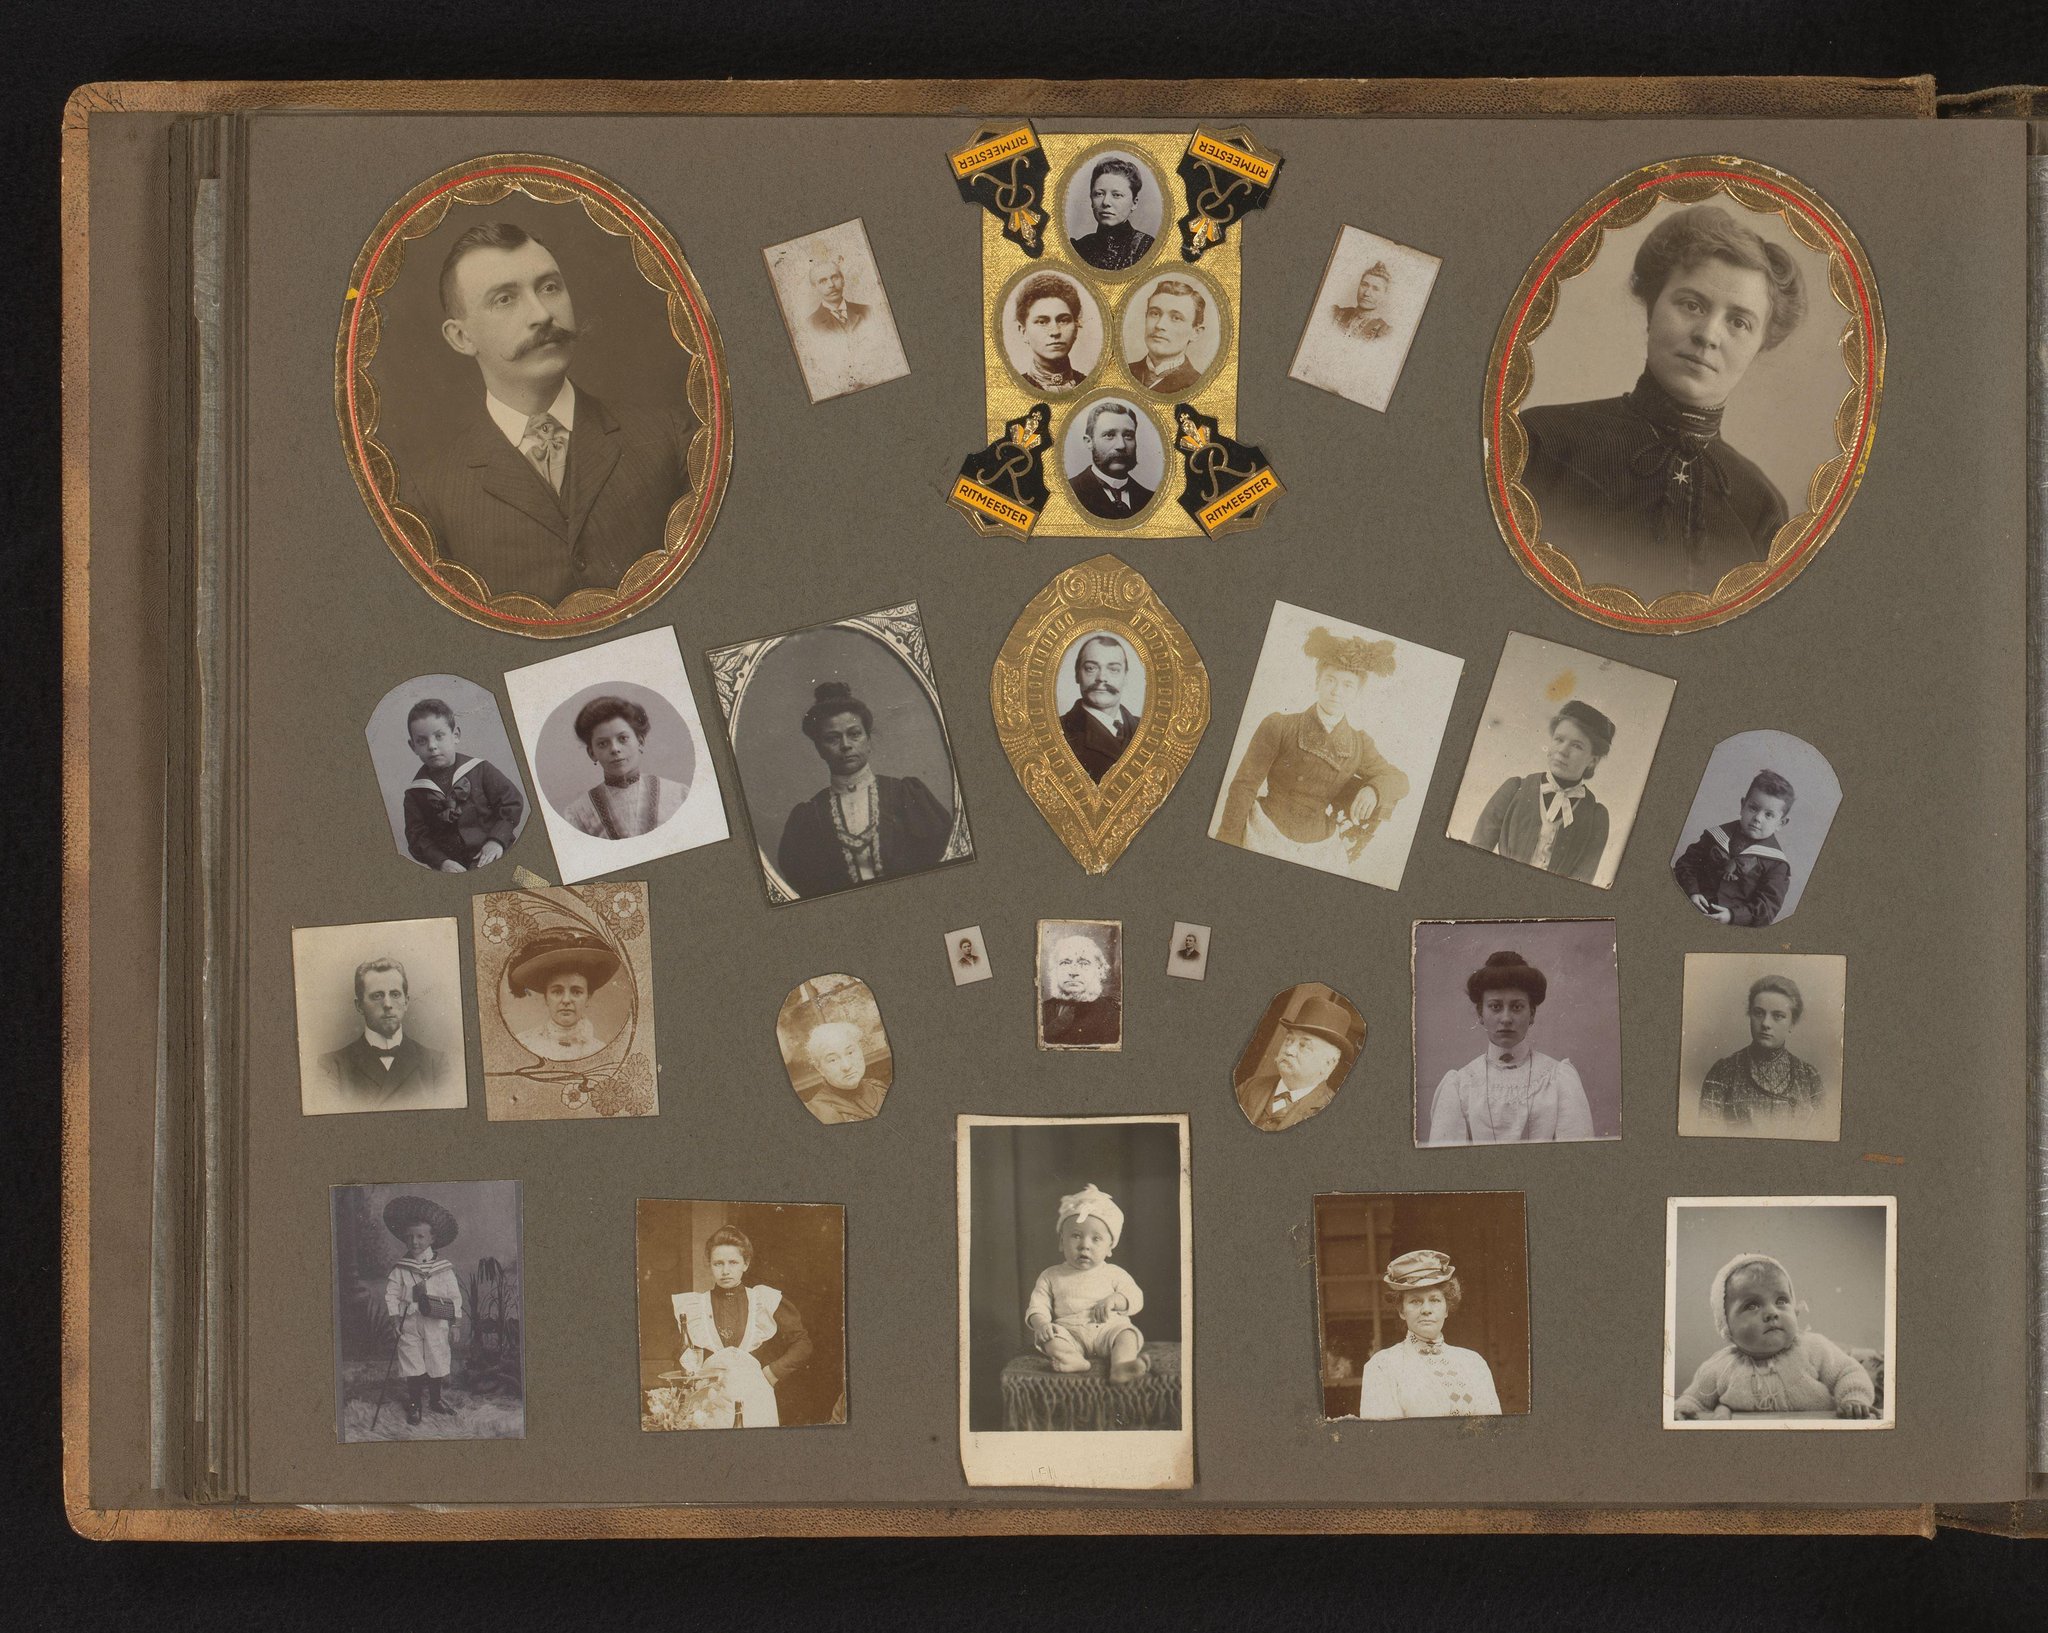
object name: photograph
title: Fotocollage van negenentwintig portretten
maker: Anonymous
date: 1900-1950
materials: paper, photographic support, textile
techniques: collodion silver print, gelatin silver print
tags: adult woman, adult man, historical persons, youth, adolescent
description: Negenentwintig portretten van mannen, vrouwen en kinderen. Van sommige personen staan meerdere portretten op deze pagina. Deze pagina maakt deel uit van een album.